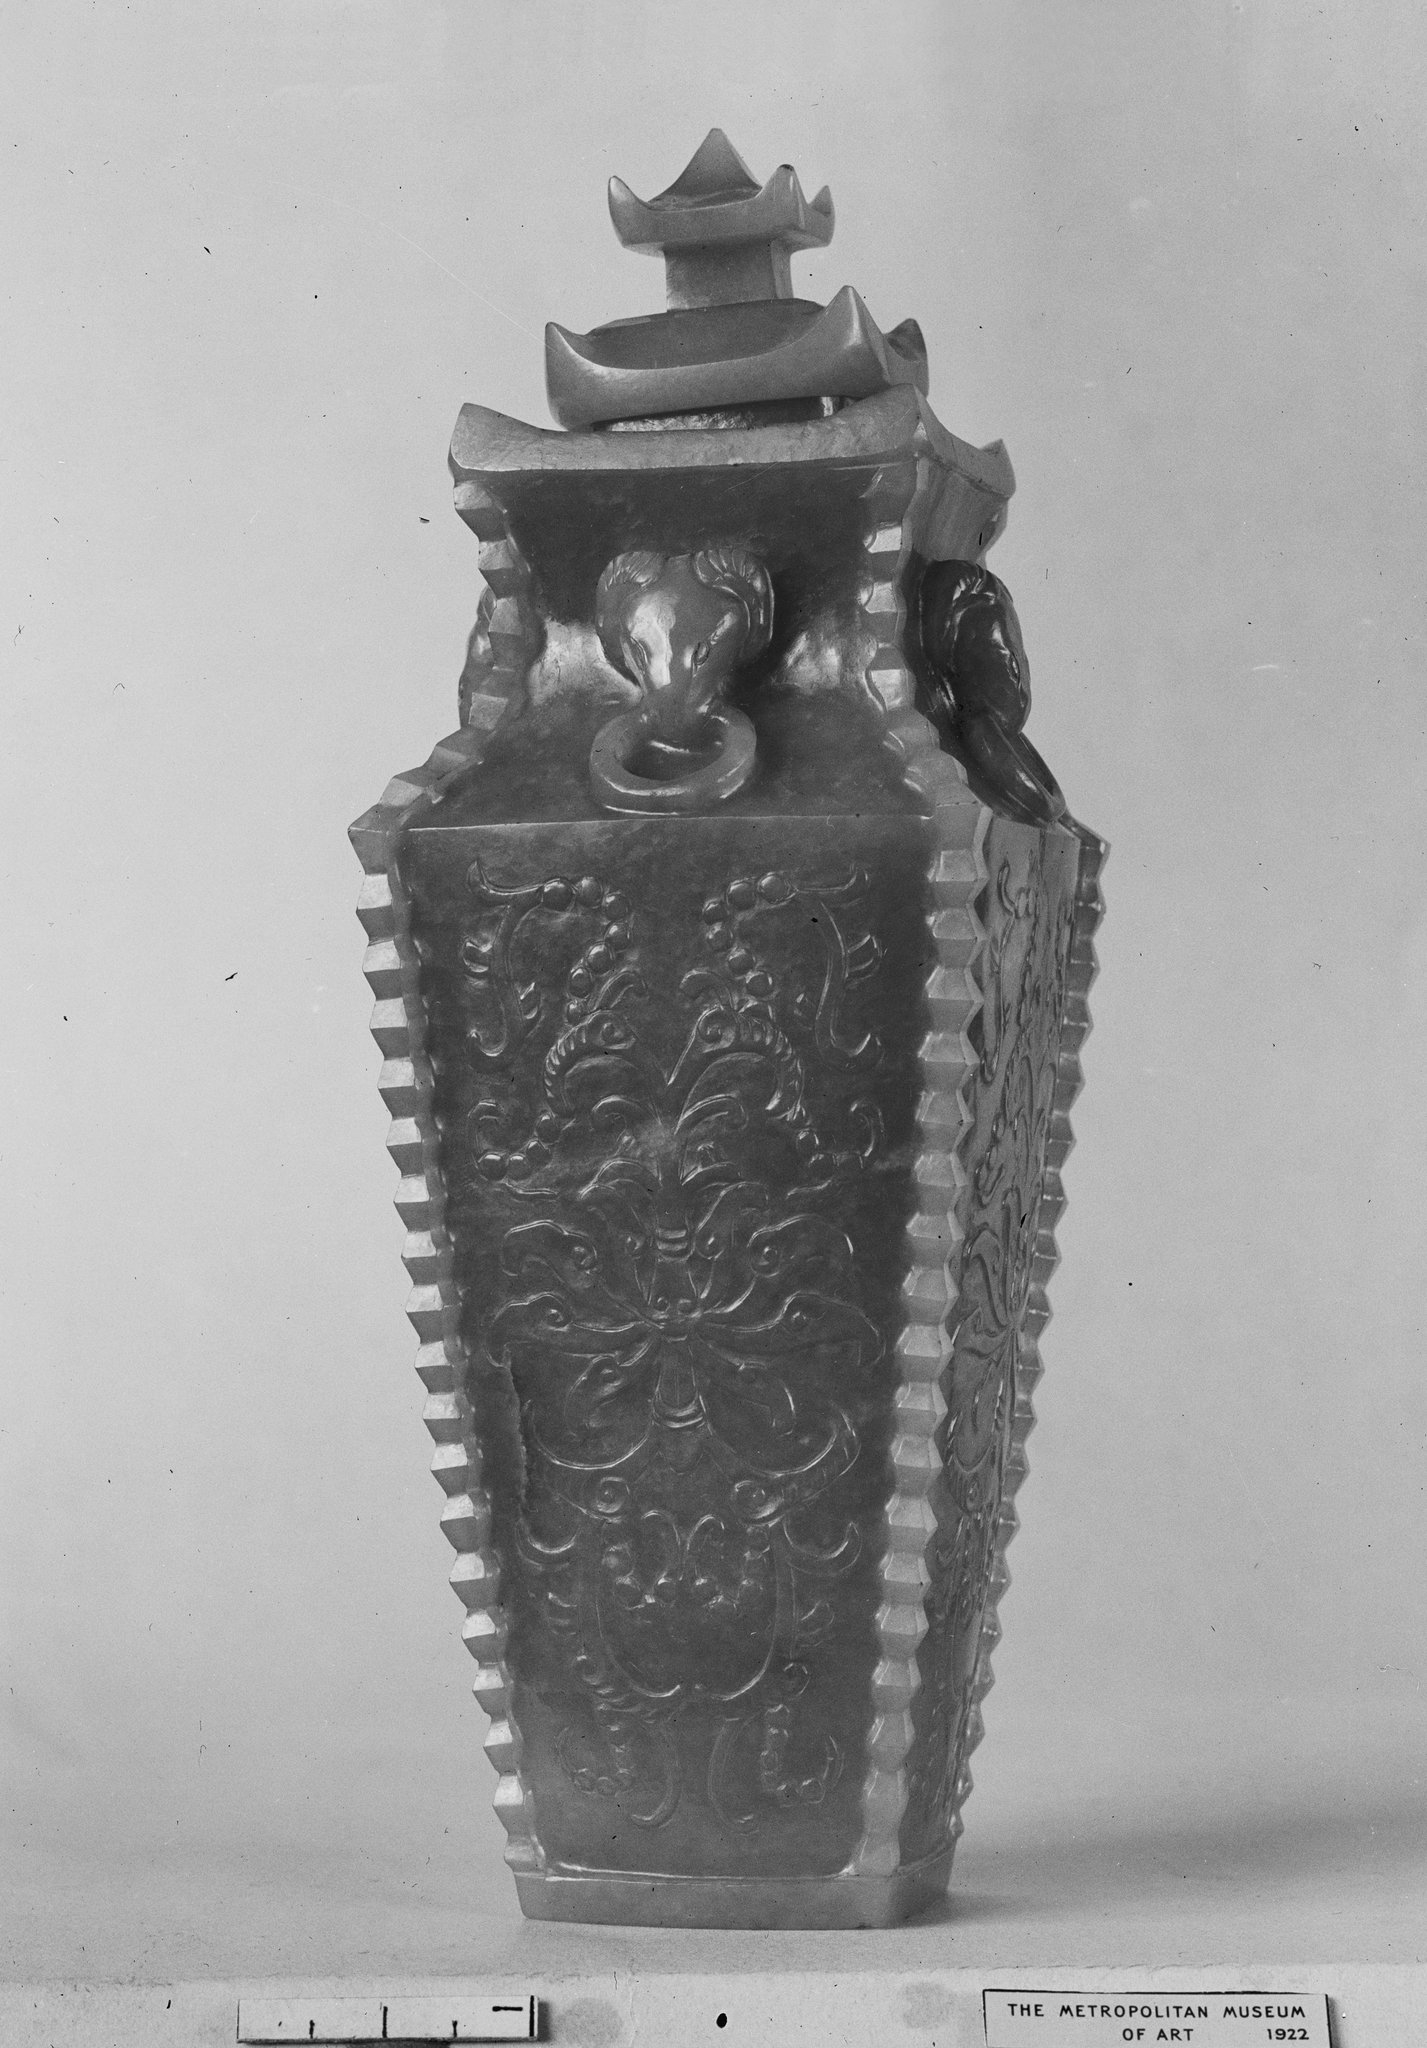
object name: covered vase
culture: chinese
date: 1736-1795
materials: jade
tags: bulls